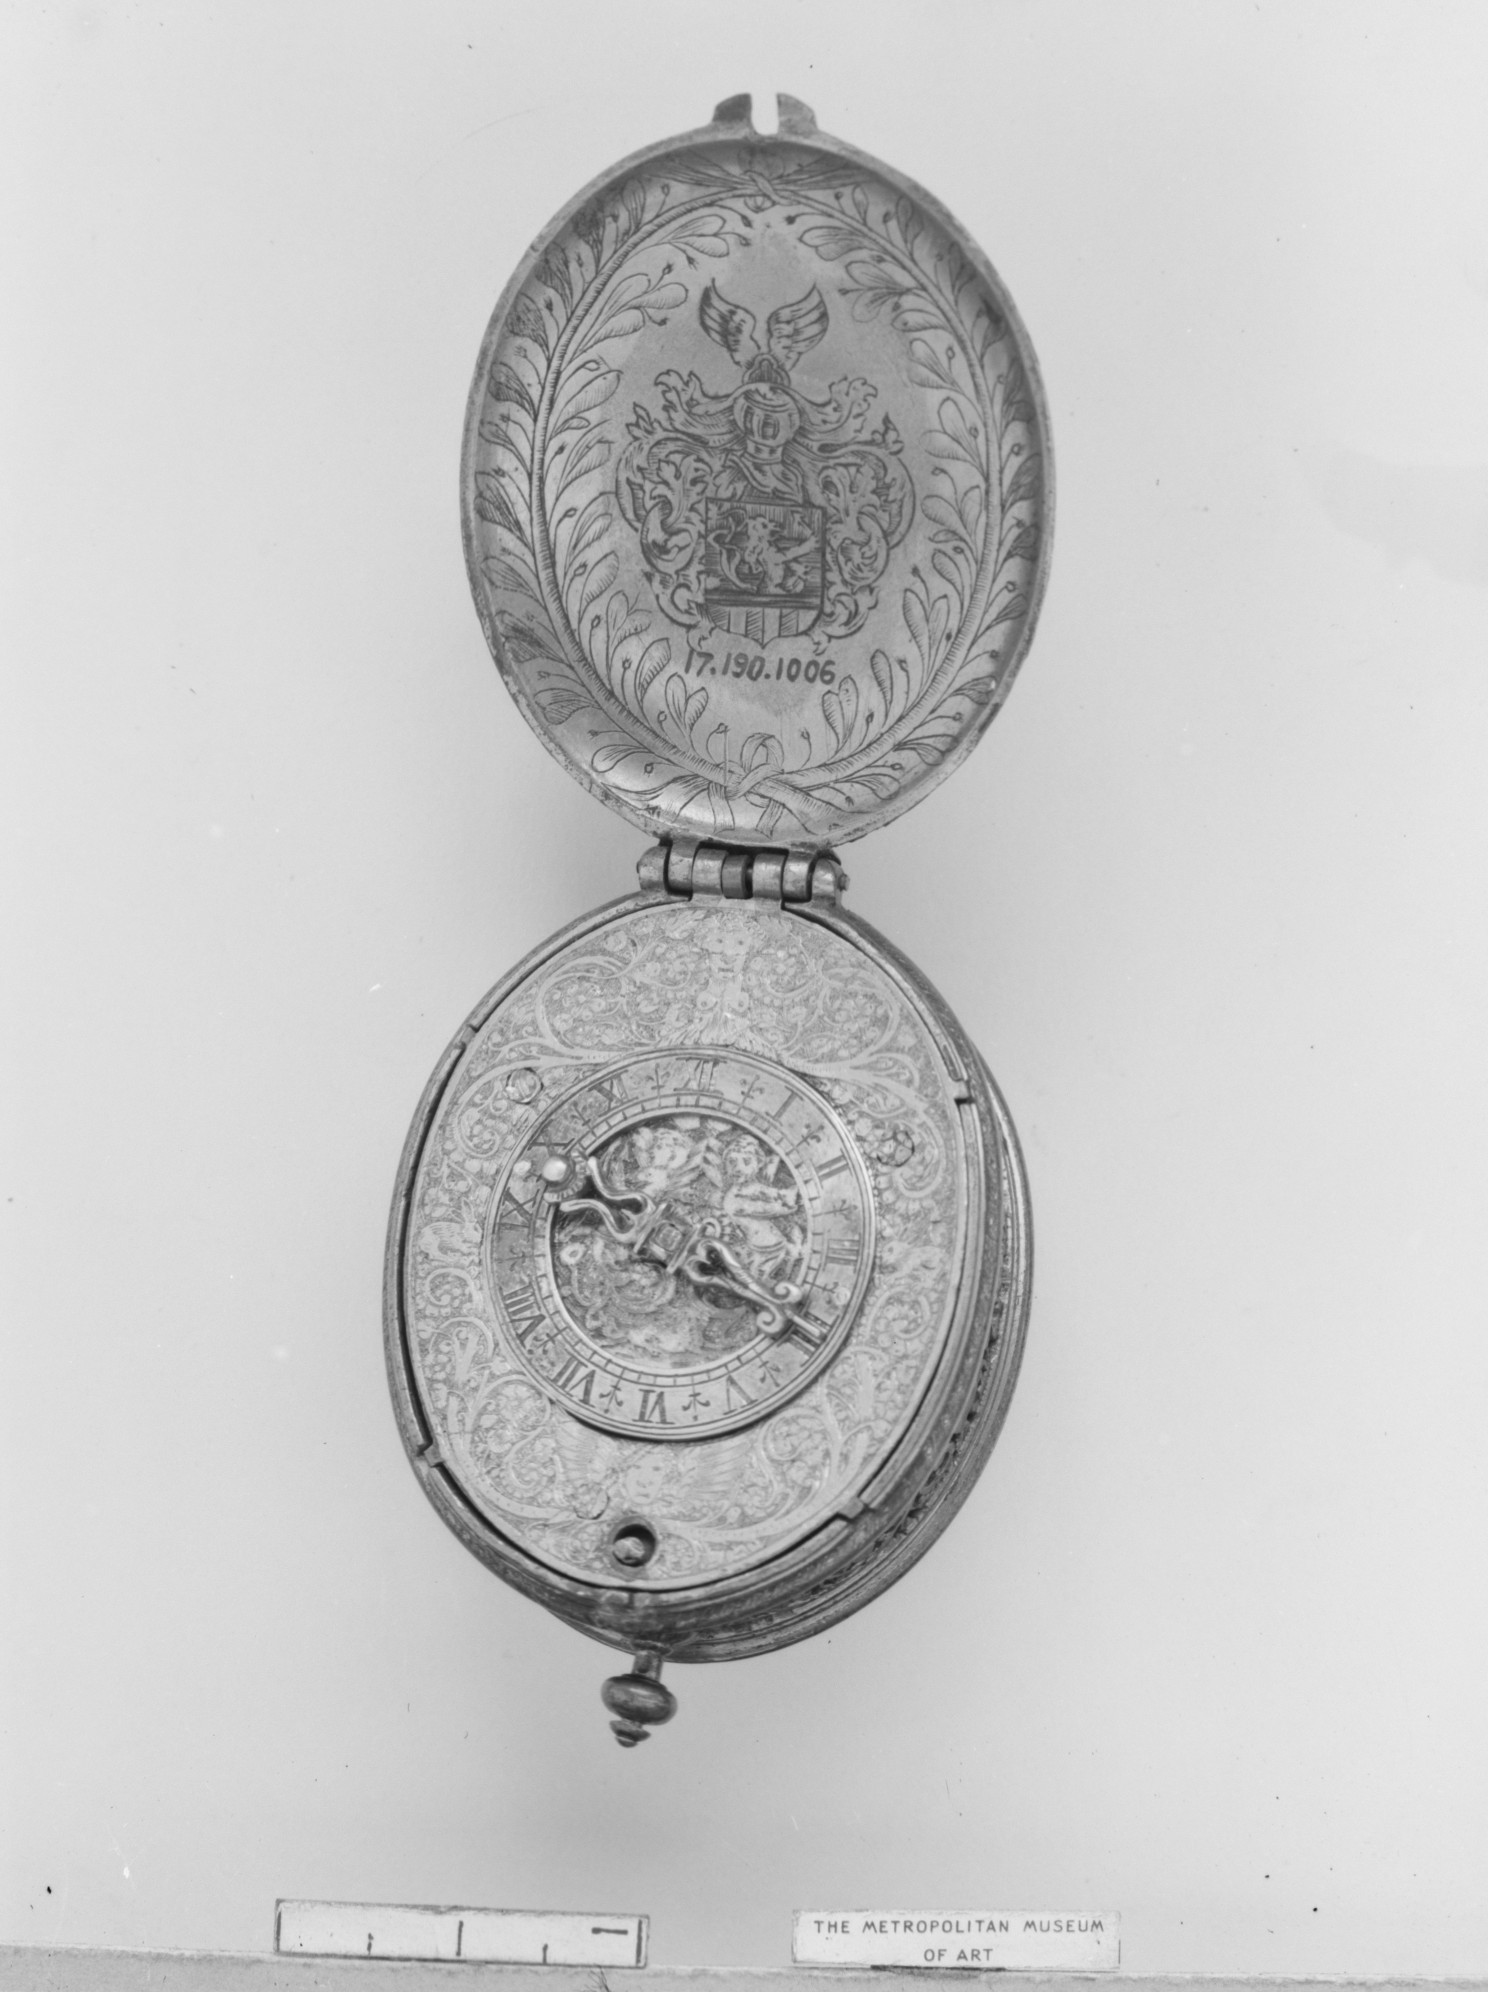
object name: watch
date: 1701-1900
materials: brass, enamel, silver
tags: coat of arms